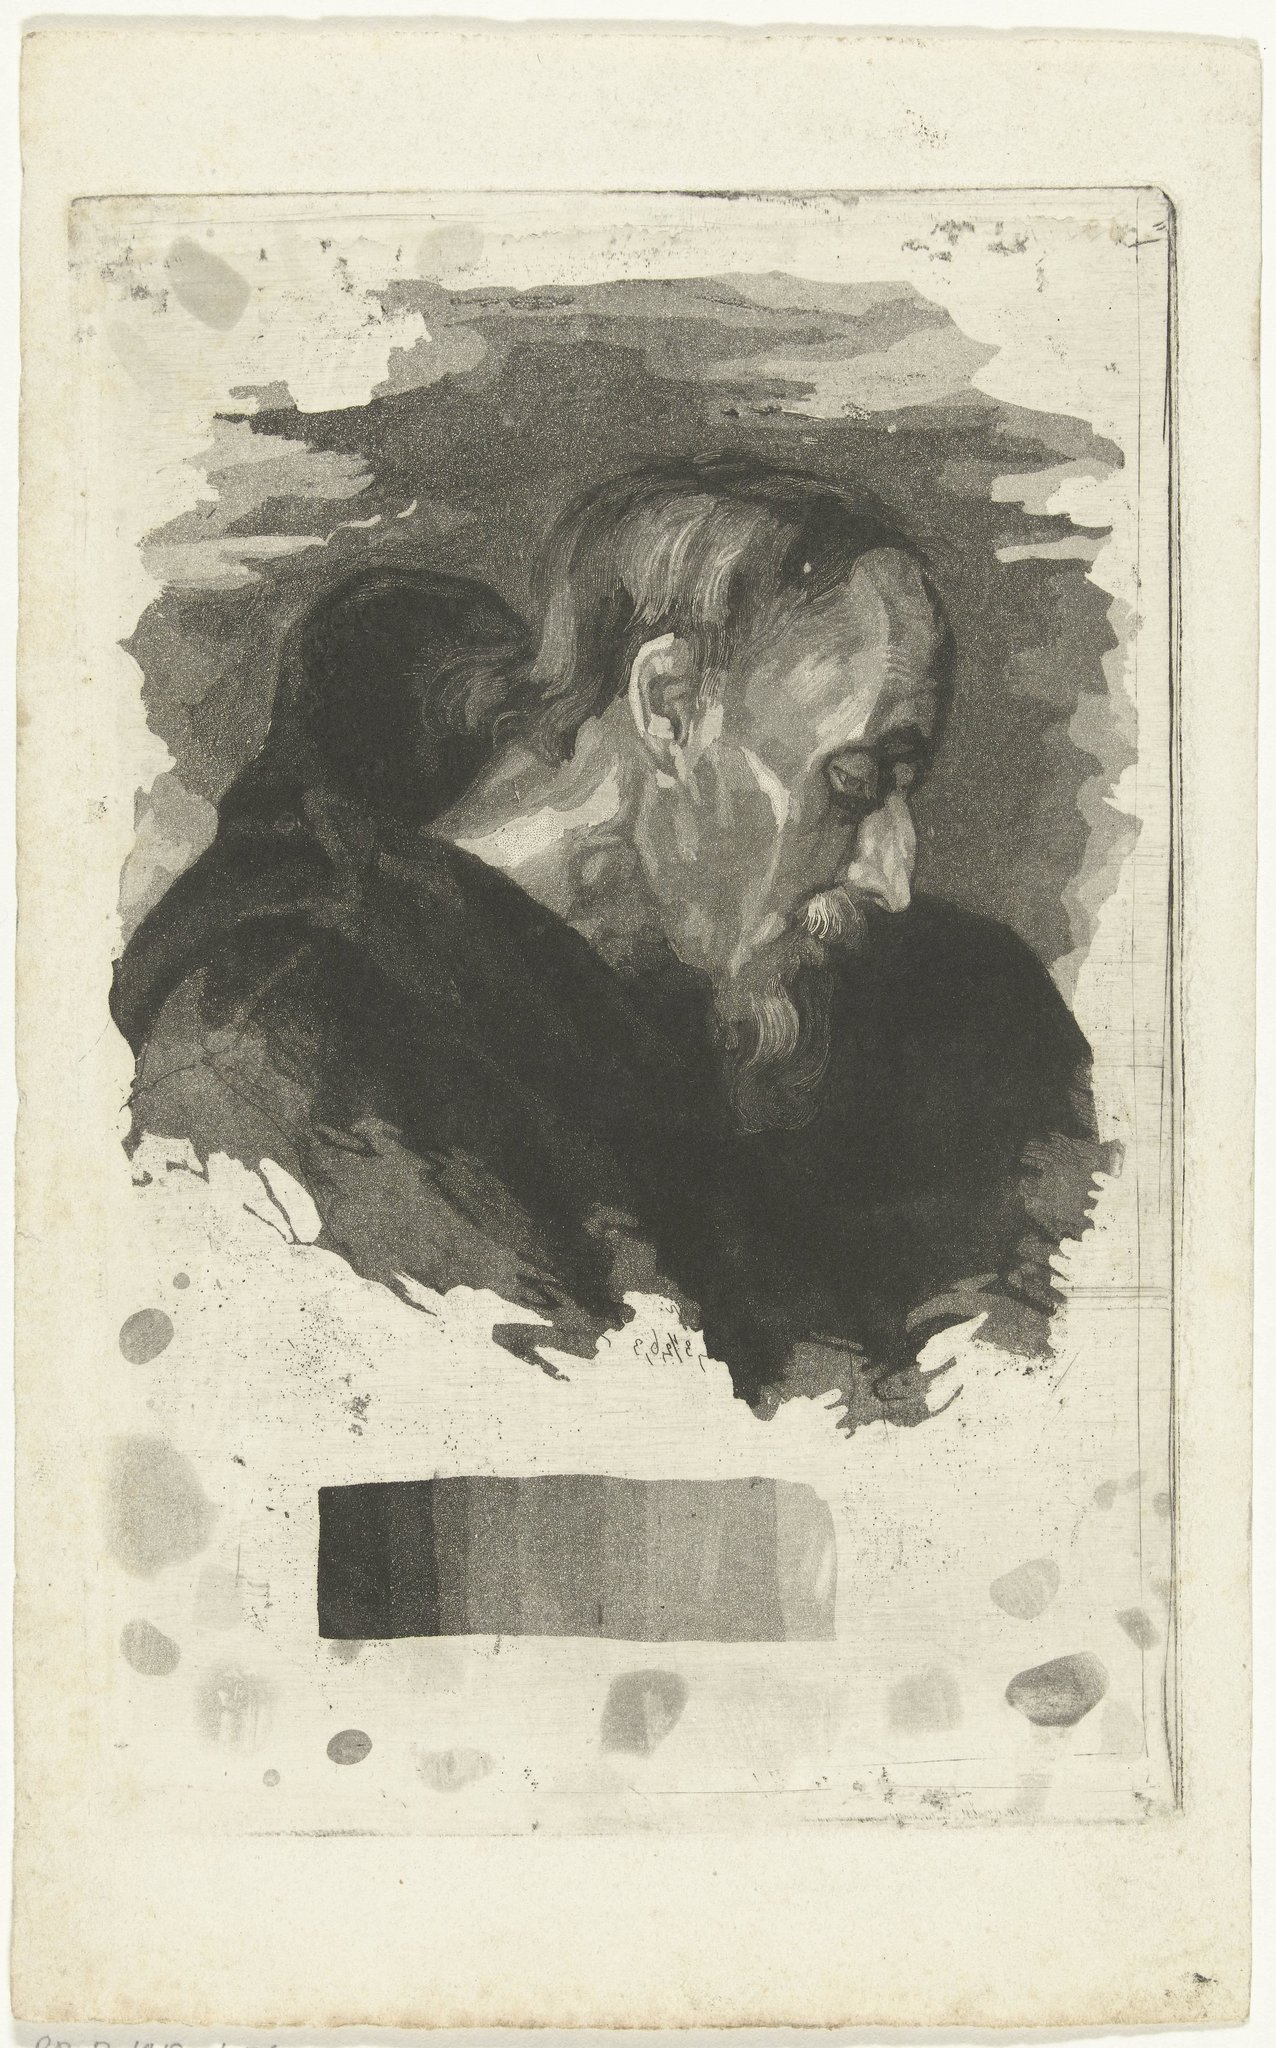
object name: print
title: Portretbuste van een monnik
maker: henricus wilhelmus couwenberg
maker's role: draughtsman, print maker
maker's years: 1814-1845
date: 1830-1845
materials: paper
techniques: aquatint, etching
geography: amsterdam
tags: monk(s), friar(s)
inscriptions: collector's mark: Lugt 2228